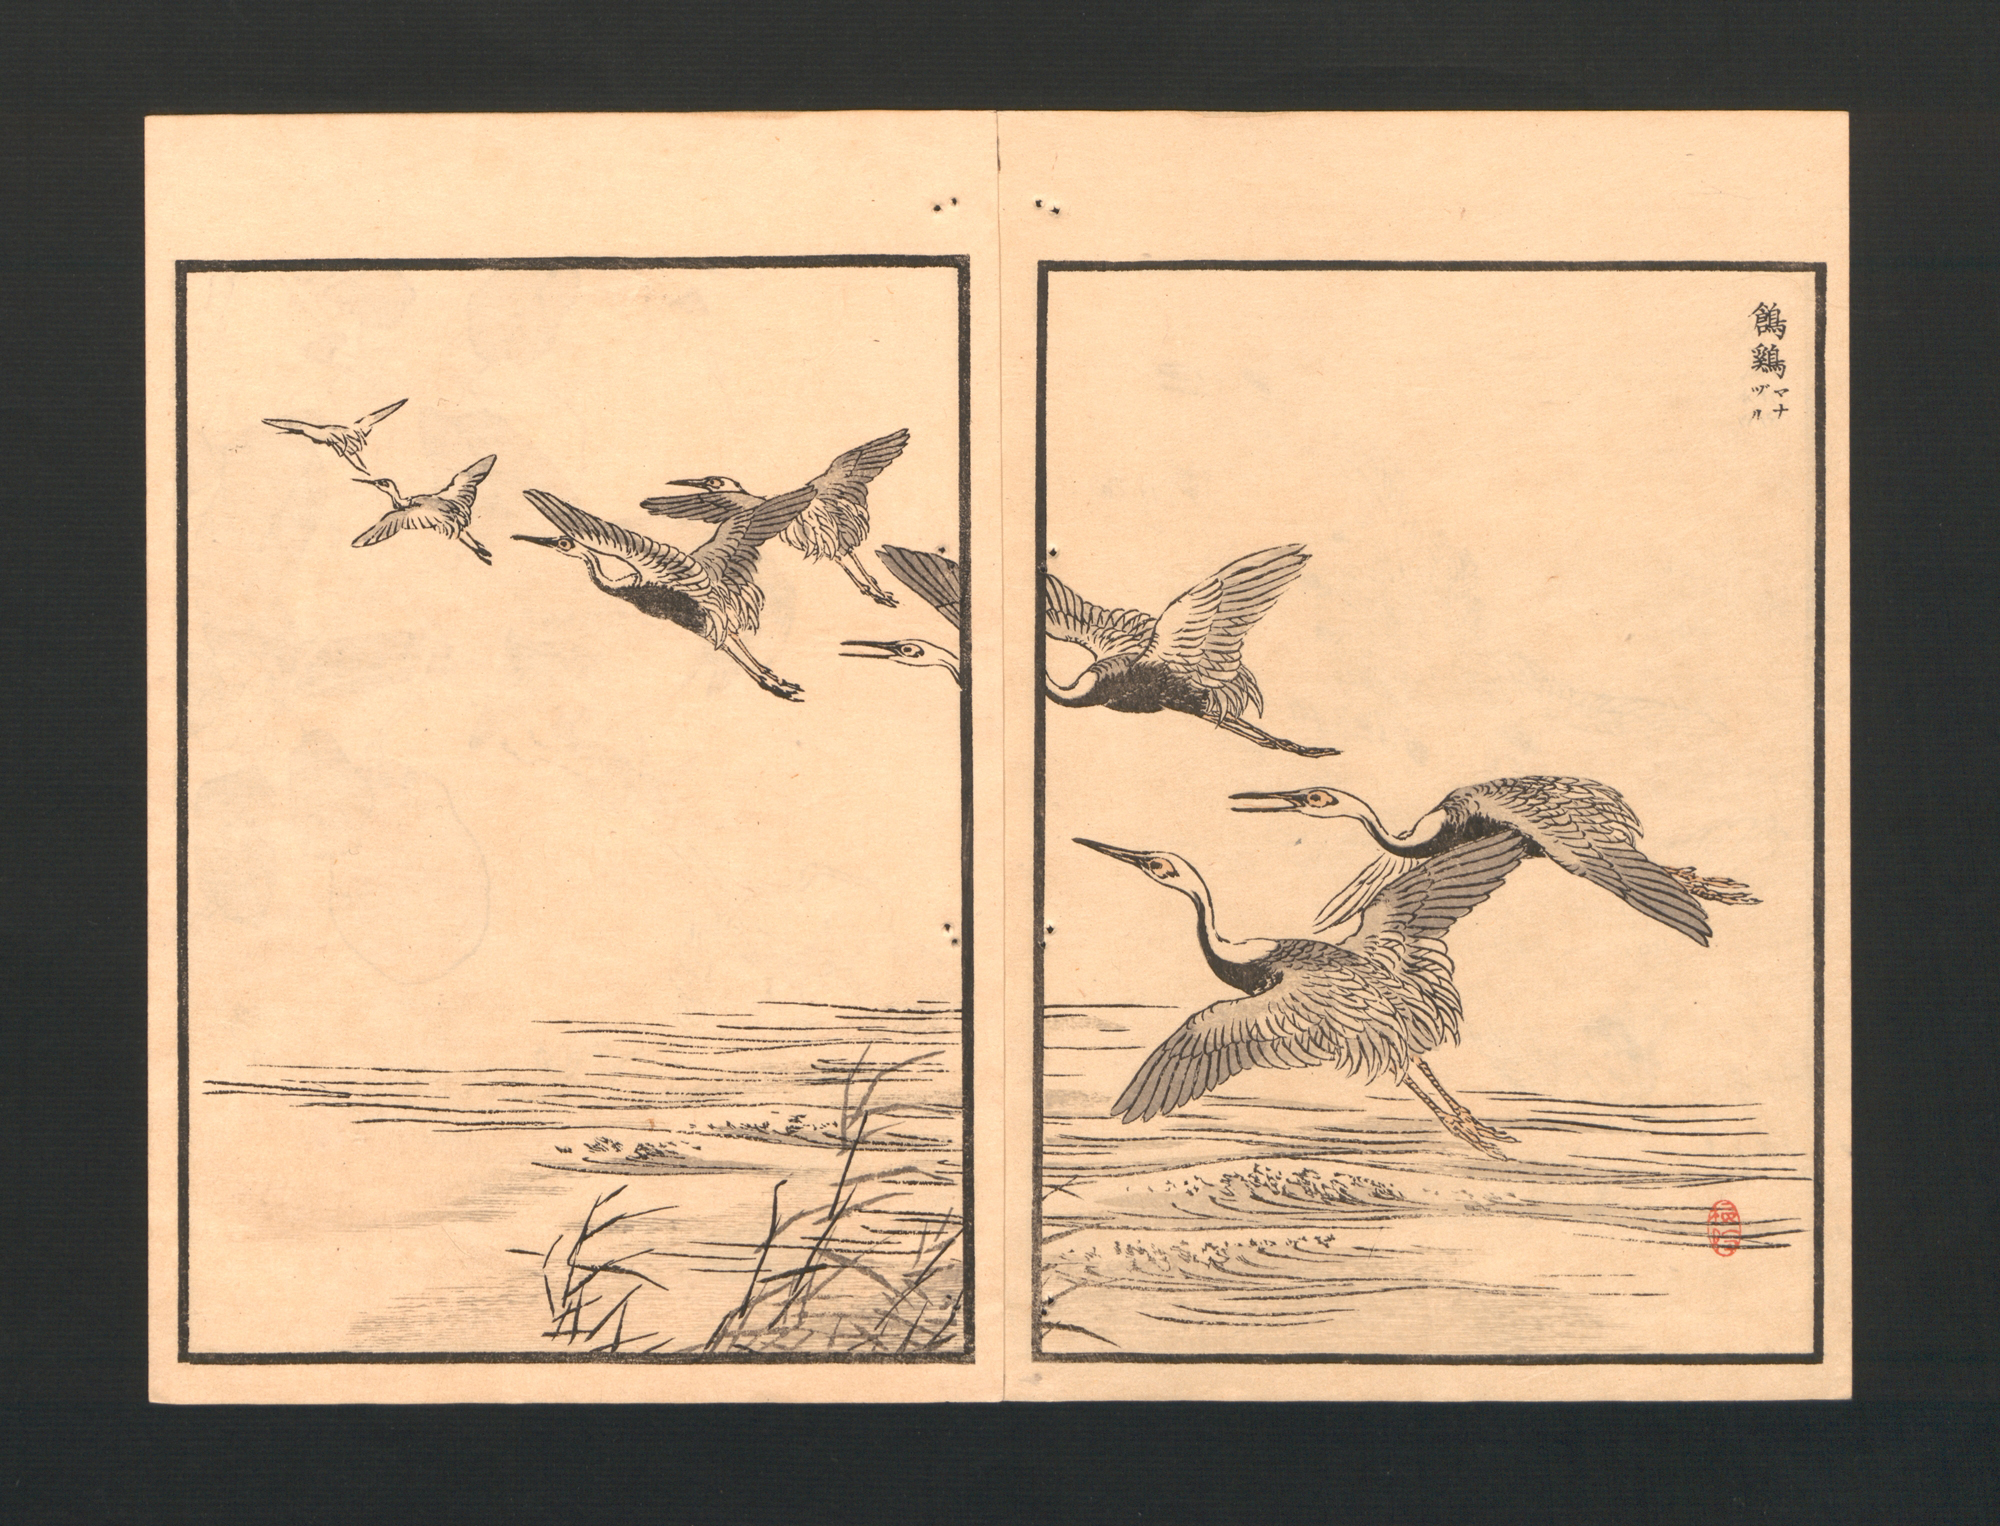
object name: illustrated book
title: Bairei Picture Album of One Hundred Birds (Bairei hyakuchō gafu) 楳嶺百鳥畫譜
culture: japanese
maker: kōno bairei 幸野楳嶺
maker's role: artist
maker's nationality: japanese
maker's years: 1844-1895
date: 1881-1884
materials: ink, paper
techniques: polychrome, woodblock print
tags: cranes